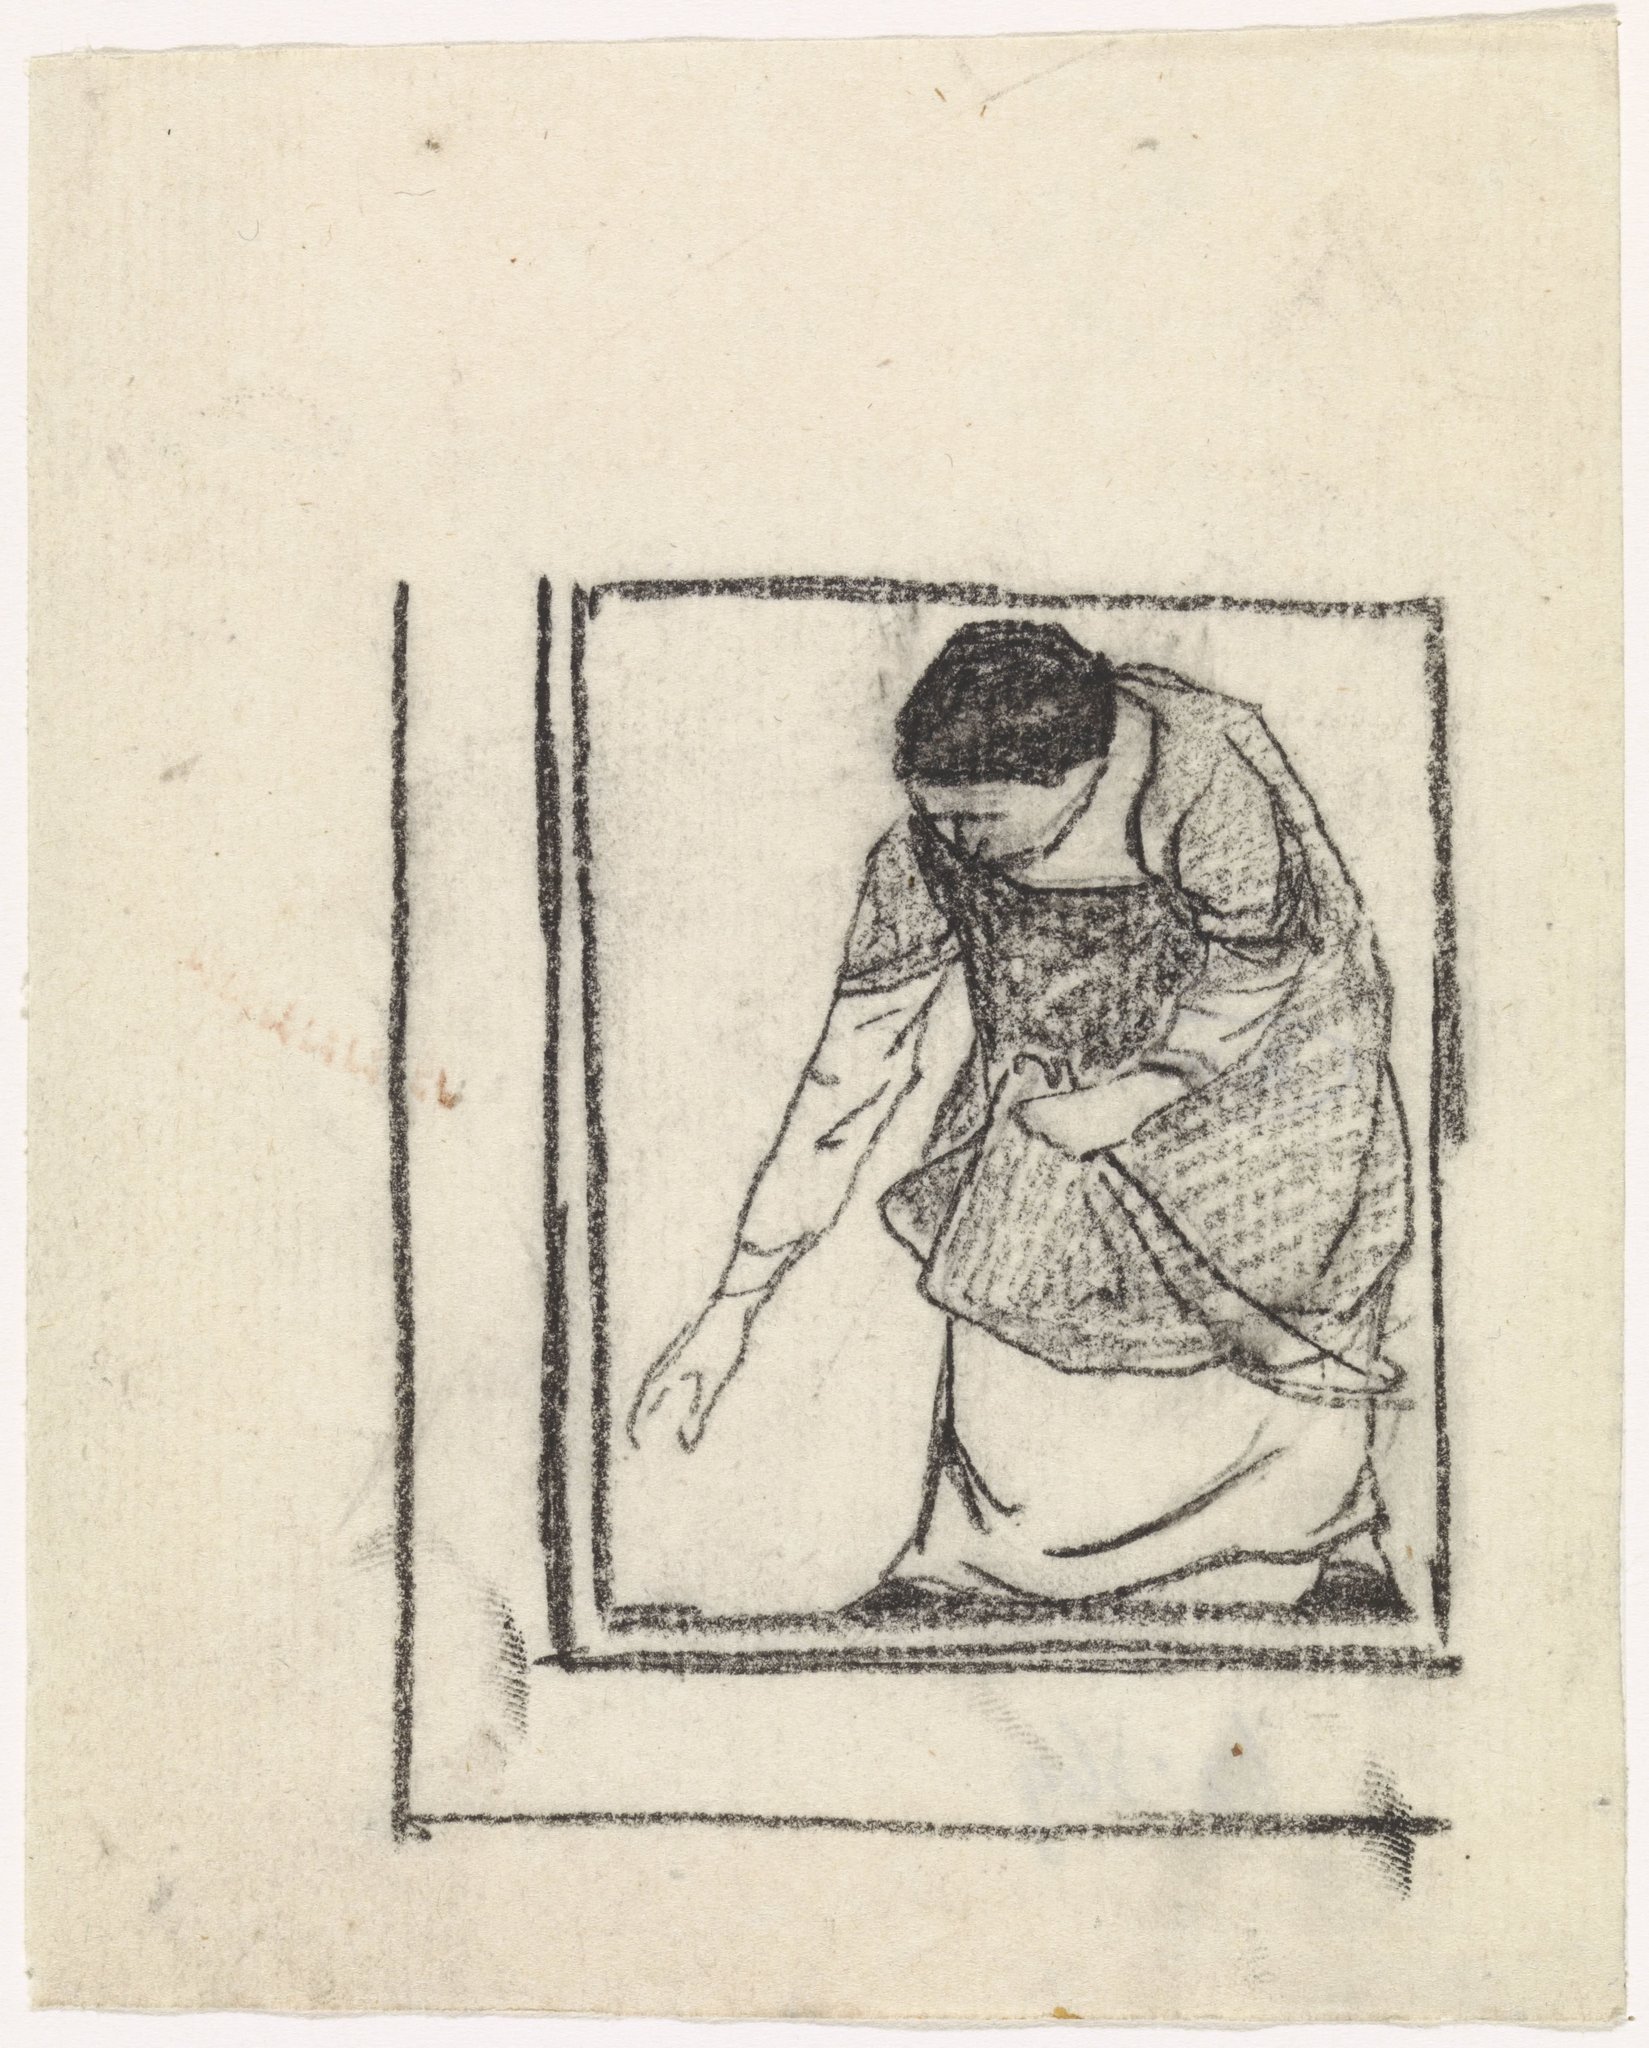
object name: drawing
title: Bukkende vrouw die objecten in haar schort verzamelt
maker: gerrit willem dijsselhof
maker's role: designer, draughtsman, print maker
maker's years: 1866-1924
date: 1876-1901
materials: chalk, paper